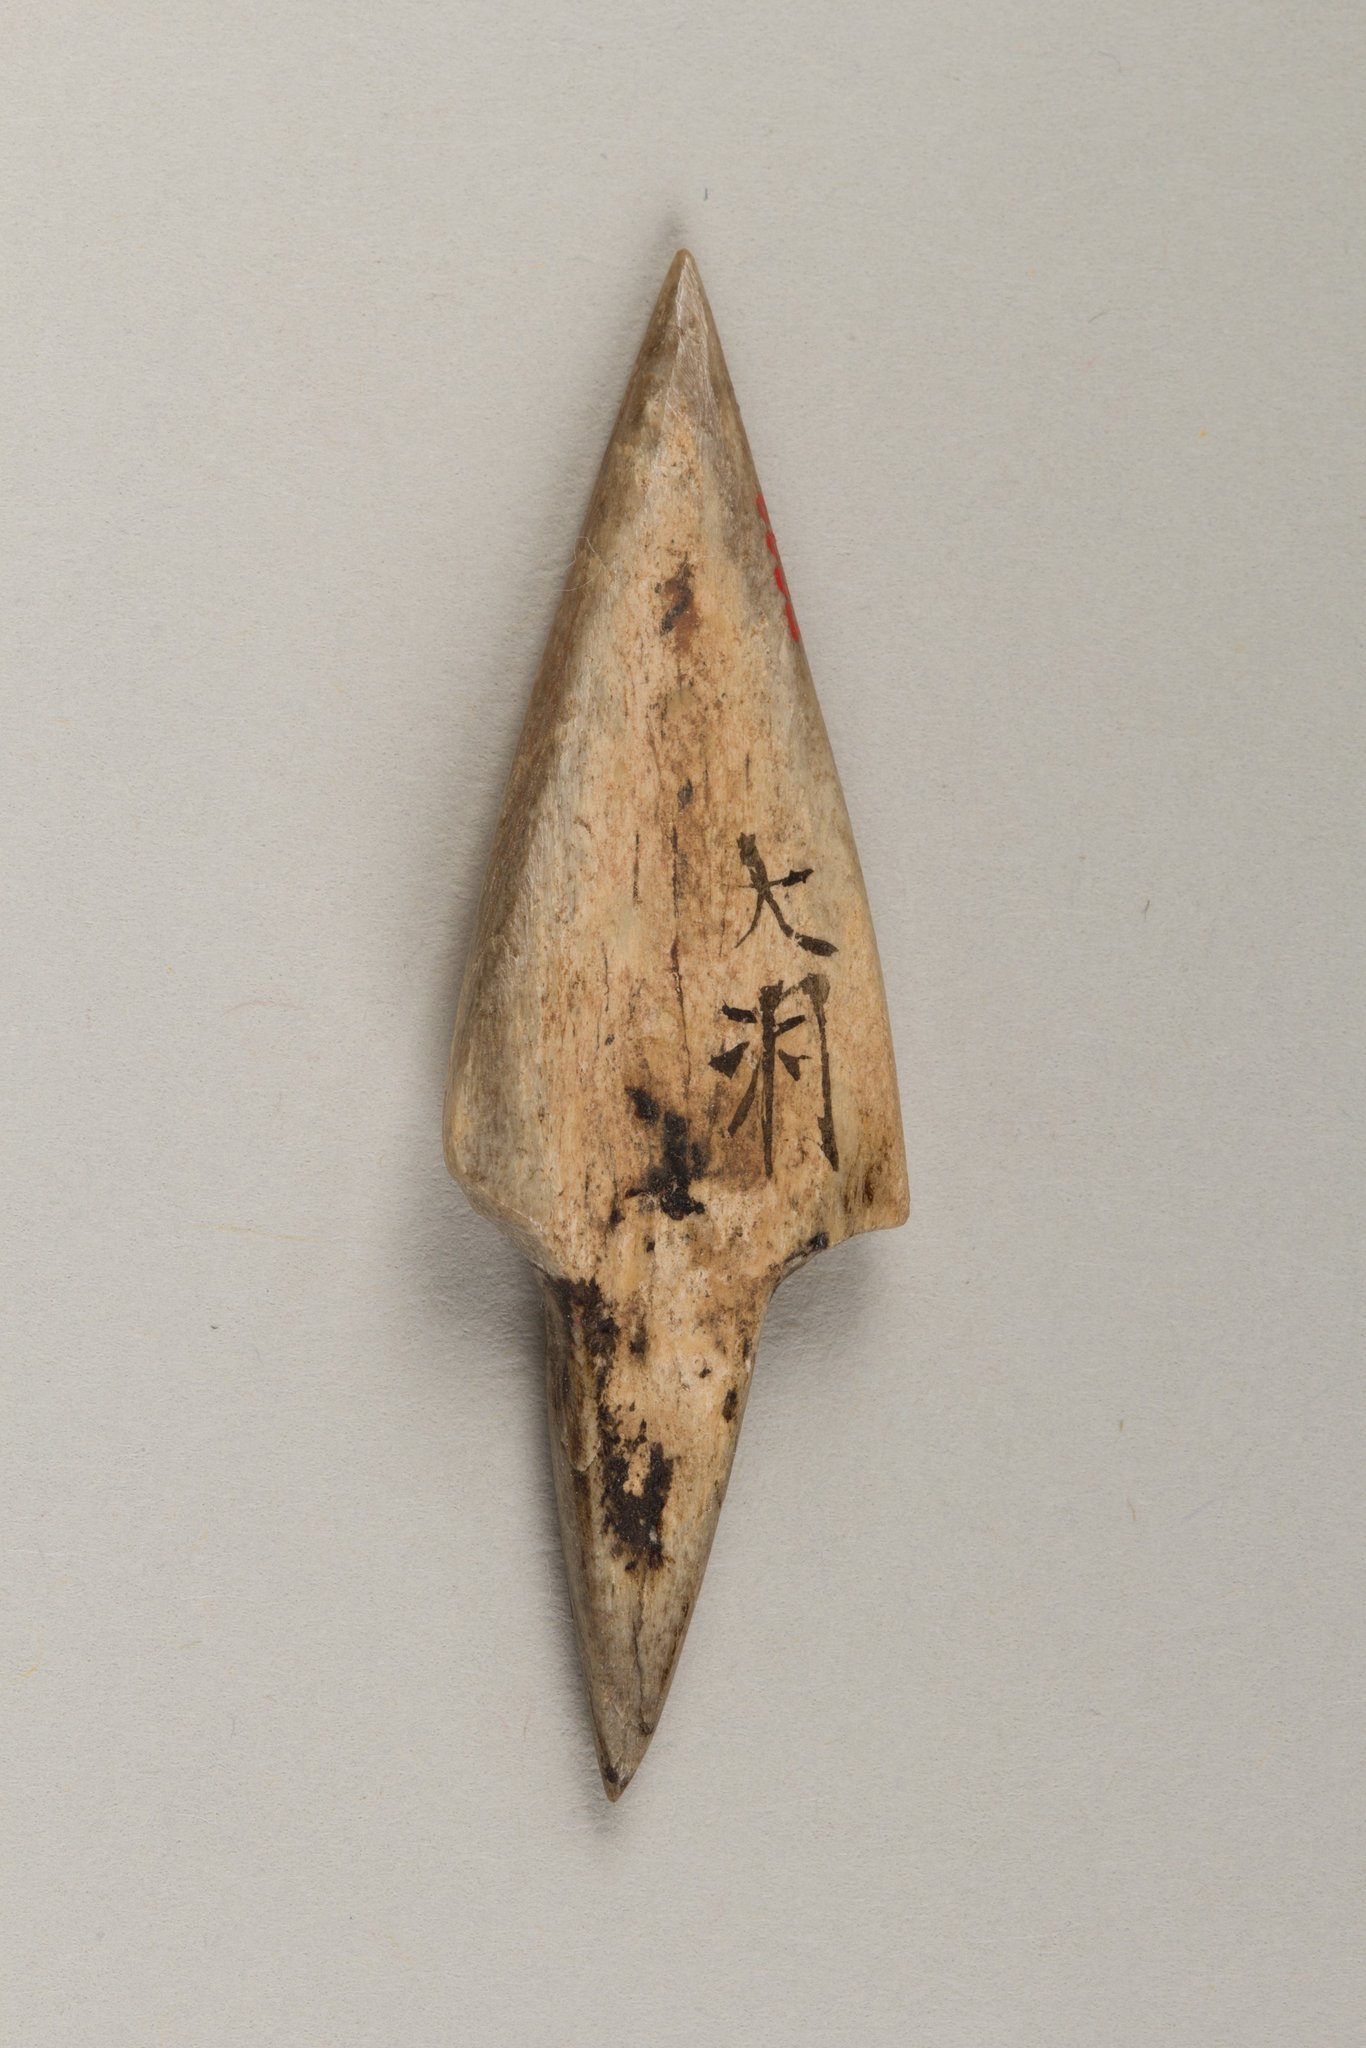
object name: arrowhead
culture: japanese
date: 1000-300 BCE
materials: bone